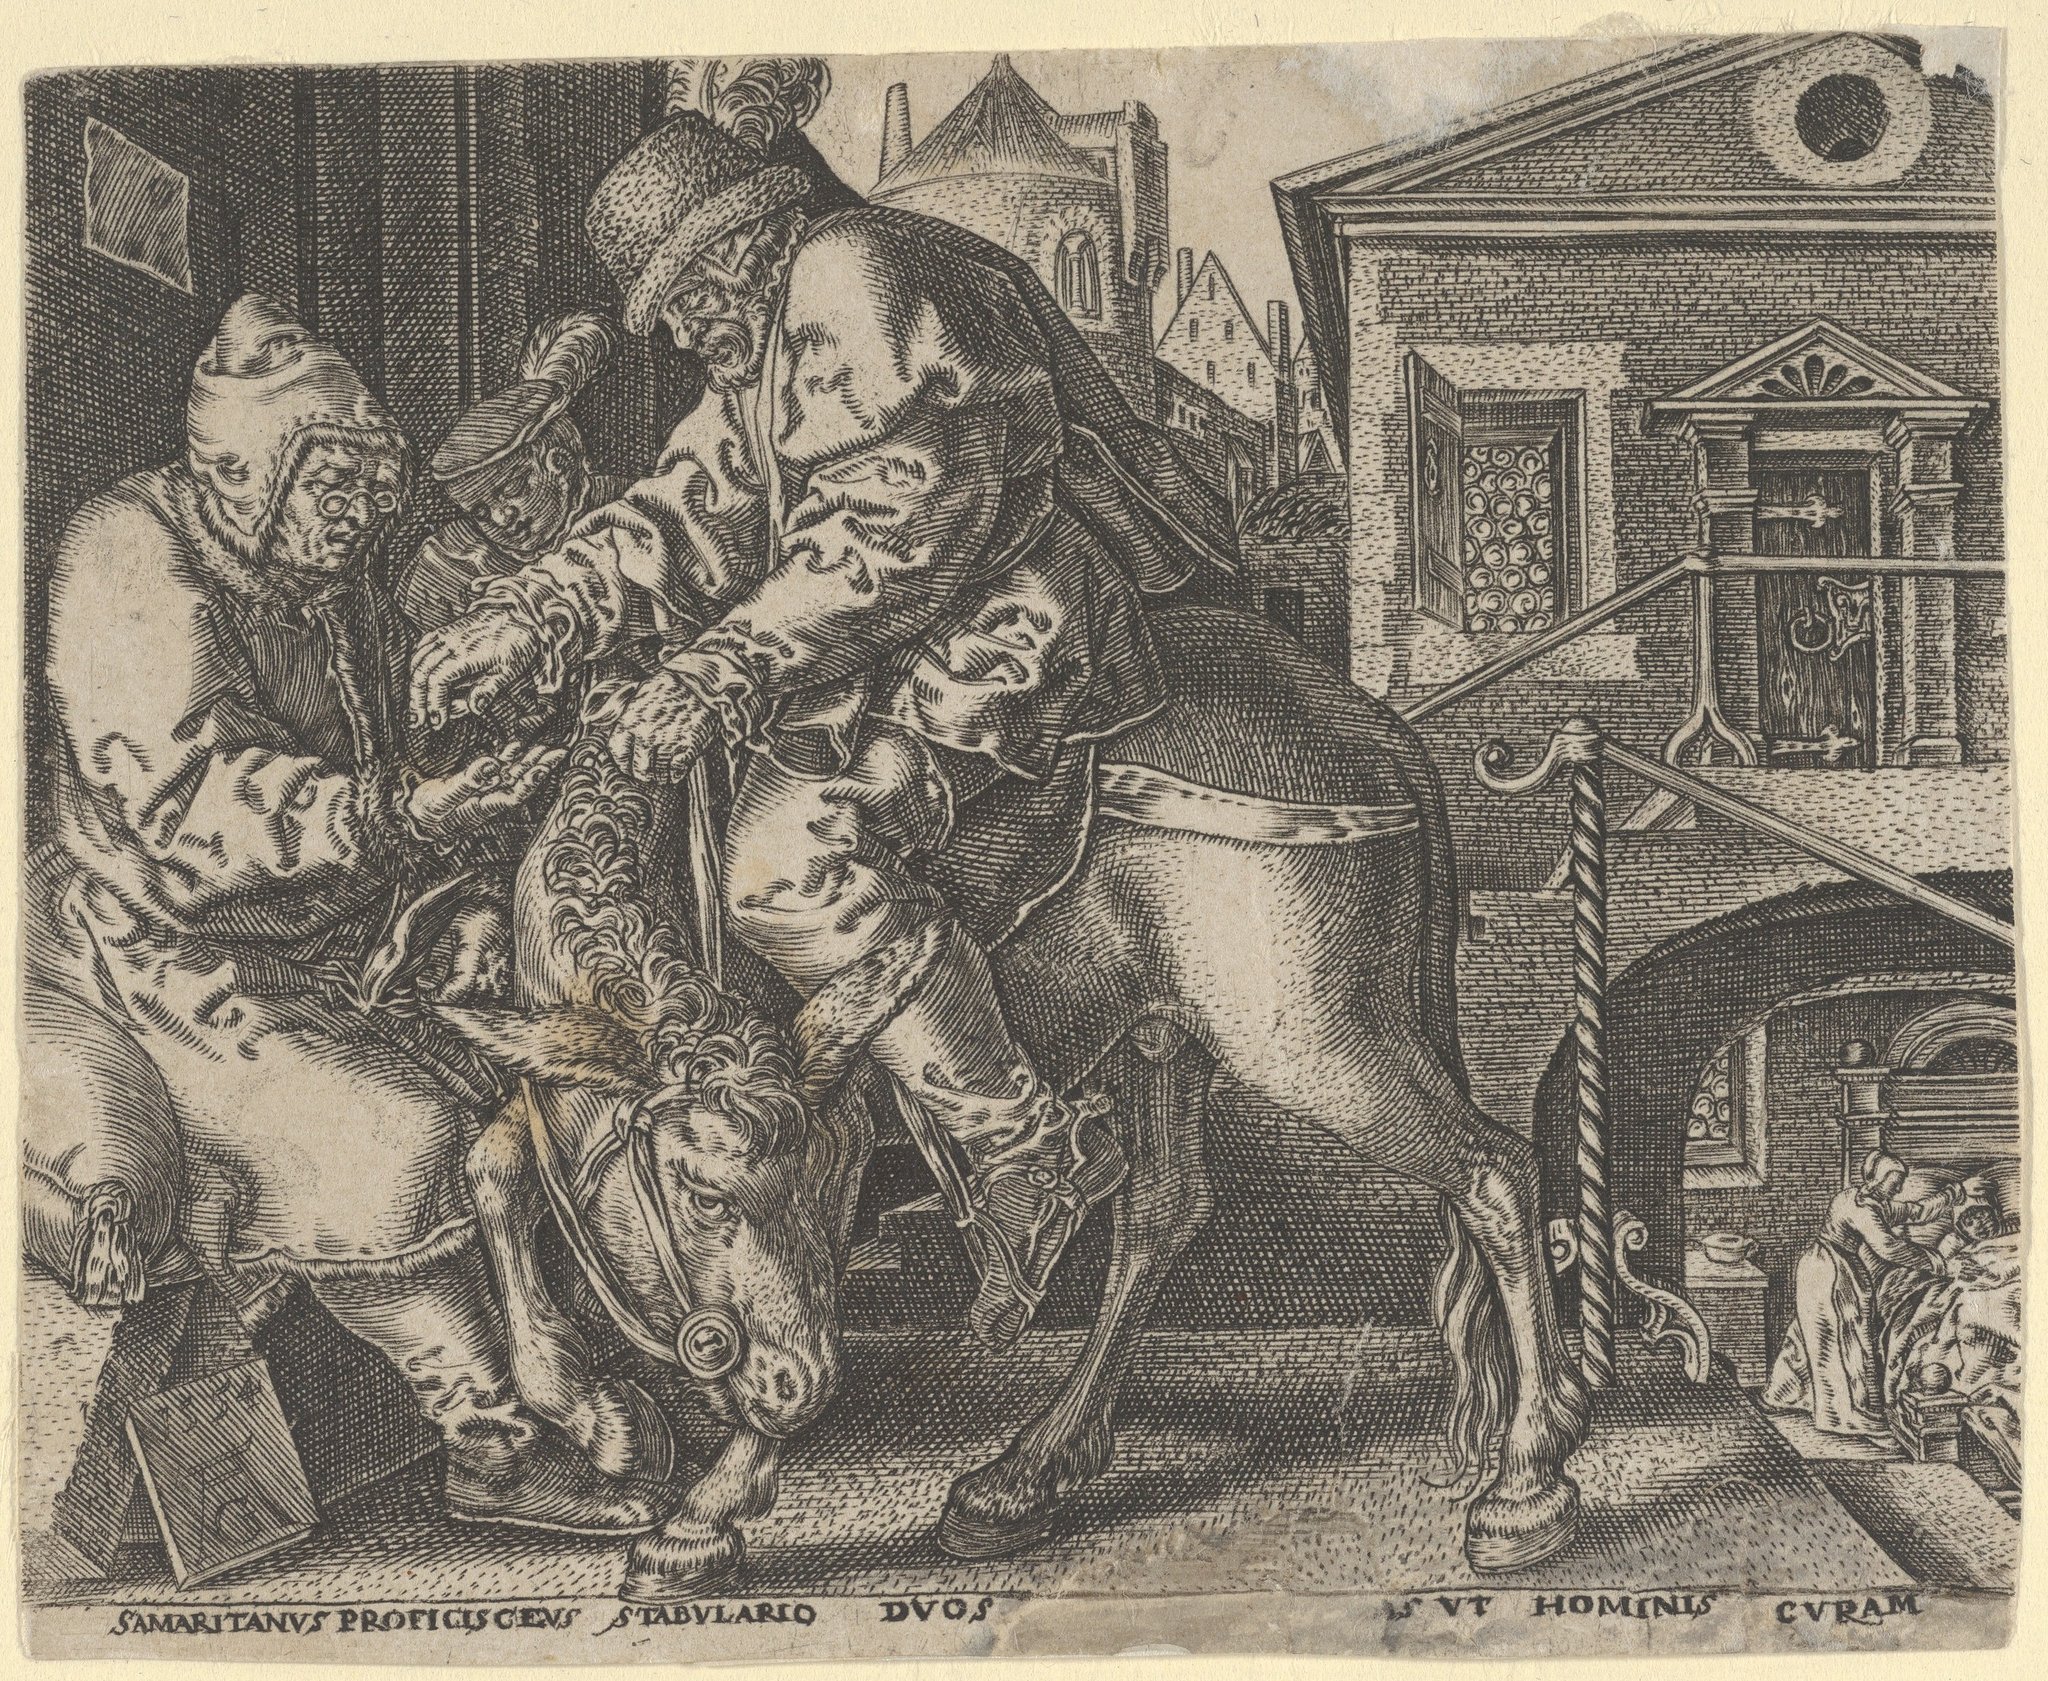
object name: print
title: Copy of The Good Samaritan Paying the Innkeeper for the Care of the Wounded Man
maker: heinrich aldegrever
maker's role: artist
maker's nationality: german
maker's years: 1502-1561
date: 1554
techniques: engraving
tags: buildings,men,donkeys